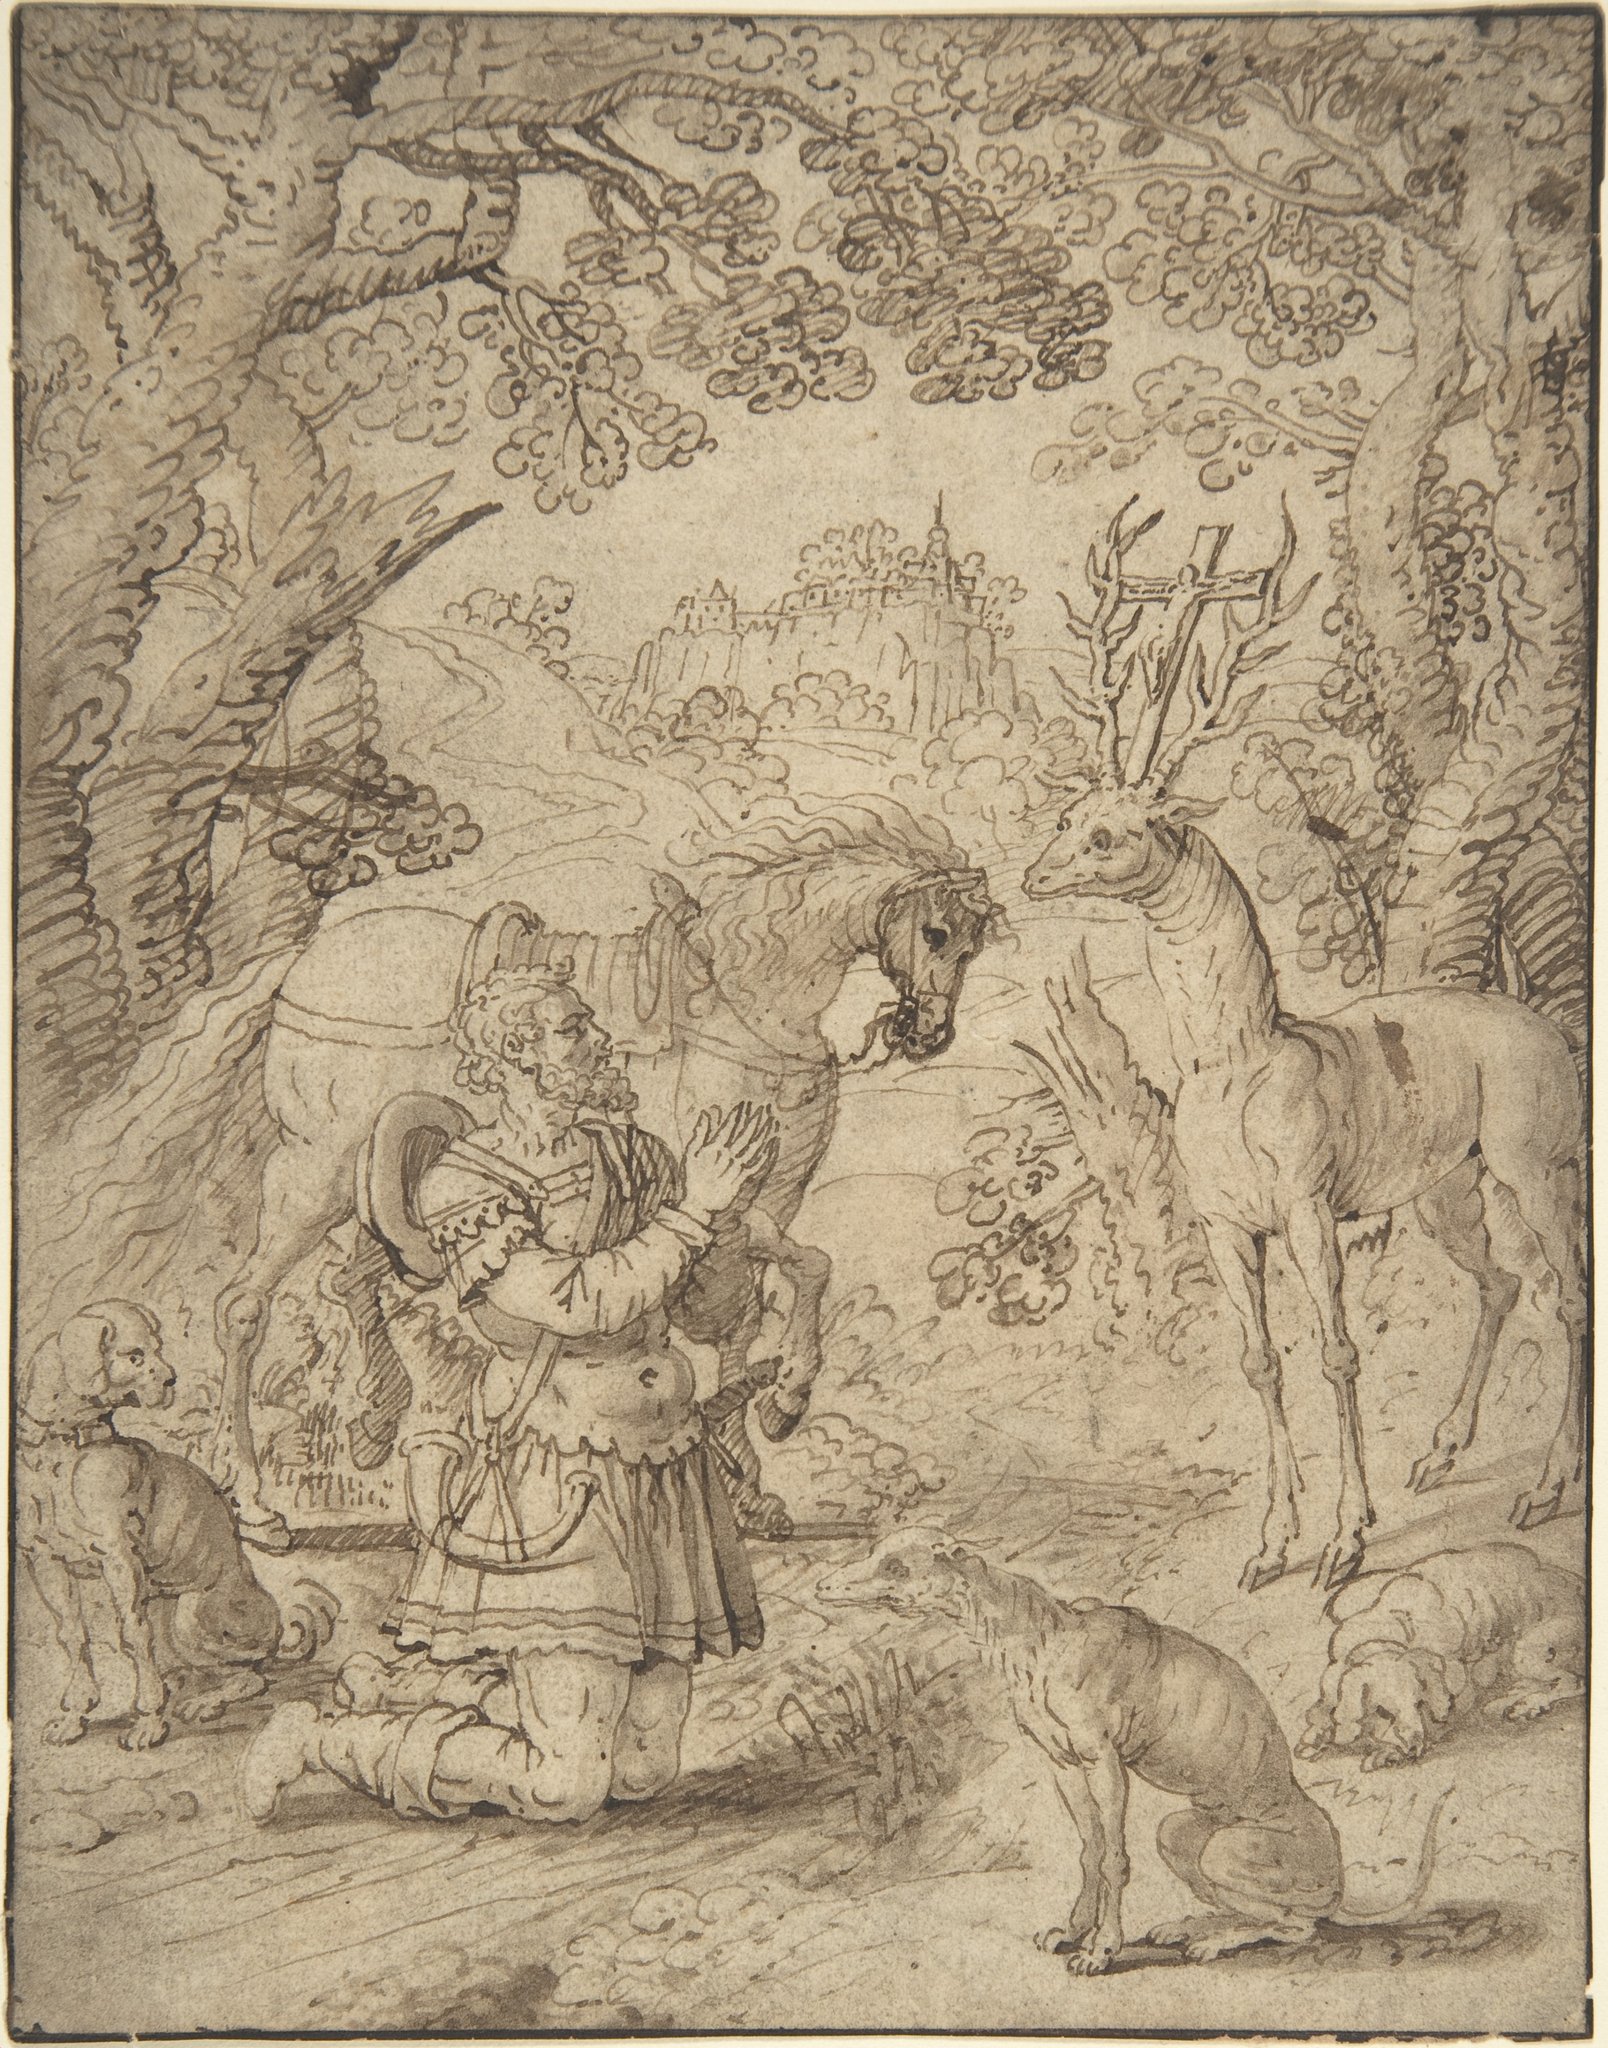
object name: drawing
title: The Vision of St. Eustace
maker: anonymous, flemish, 17th century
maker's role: artist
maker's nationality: flemish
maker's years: 1600-1700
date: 1601-1700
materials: ink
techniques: brush, pen, wash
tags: deer,dogs,horses,cross,saints